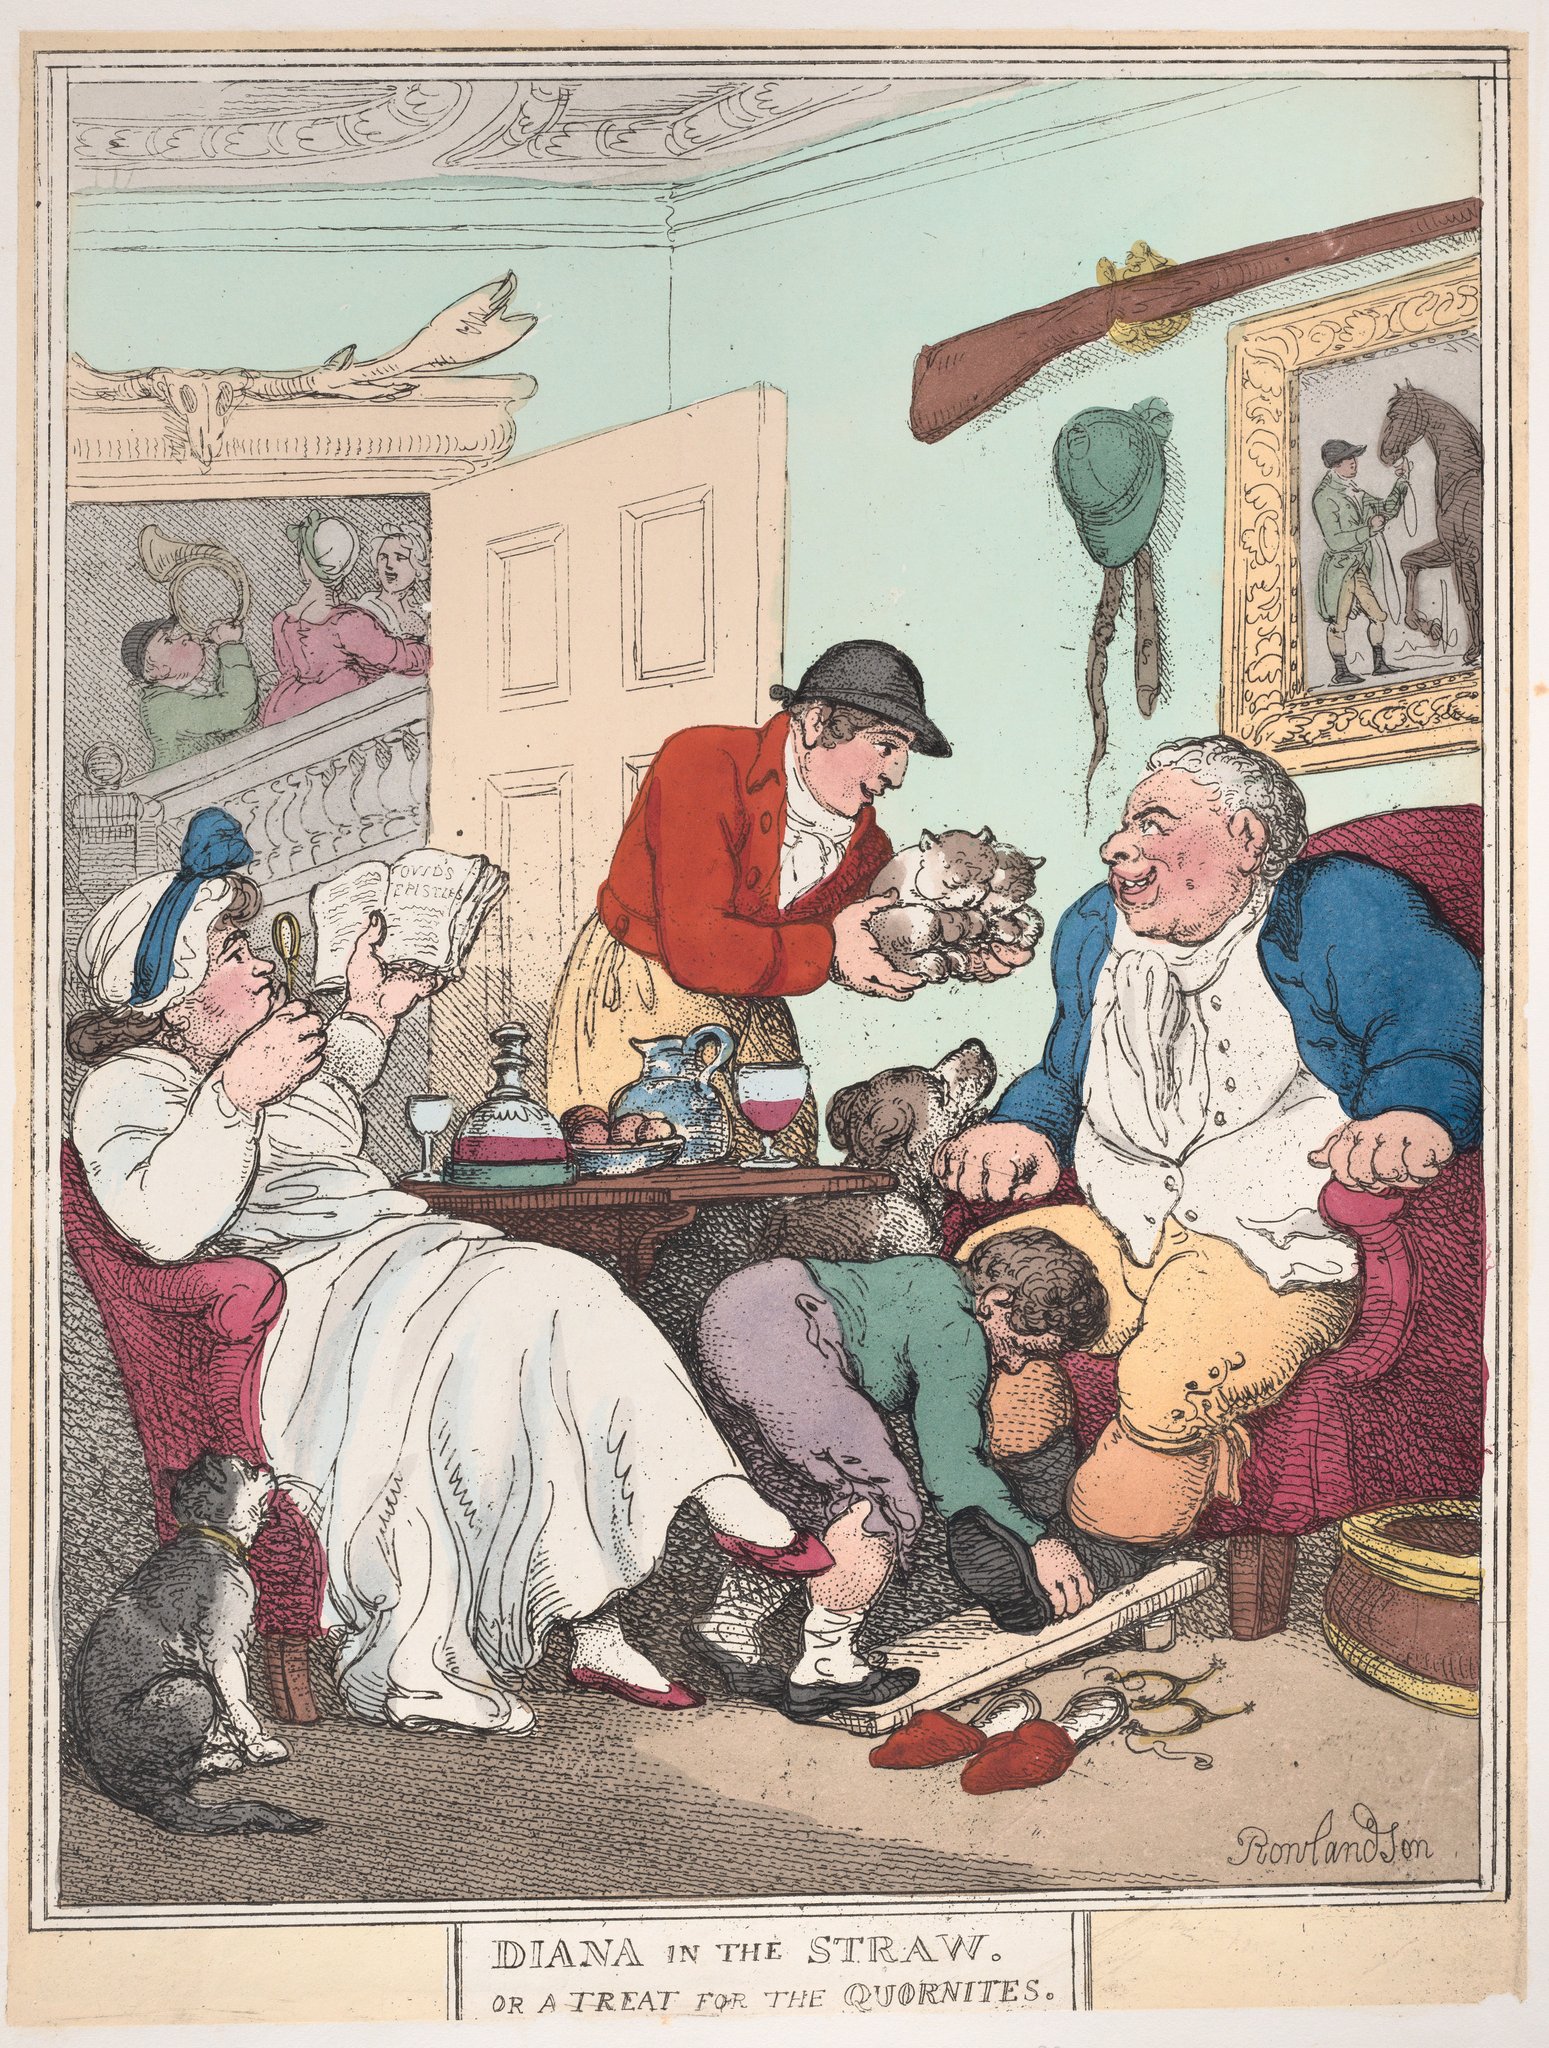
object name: print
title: Diana in the Straw, or A Treat for Quornites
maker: thomas rowlandson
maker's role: artist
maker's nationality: british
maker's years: 1757-1827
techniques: etching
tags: satire,men,women,cats,dogs